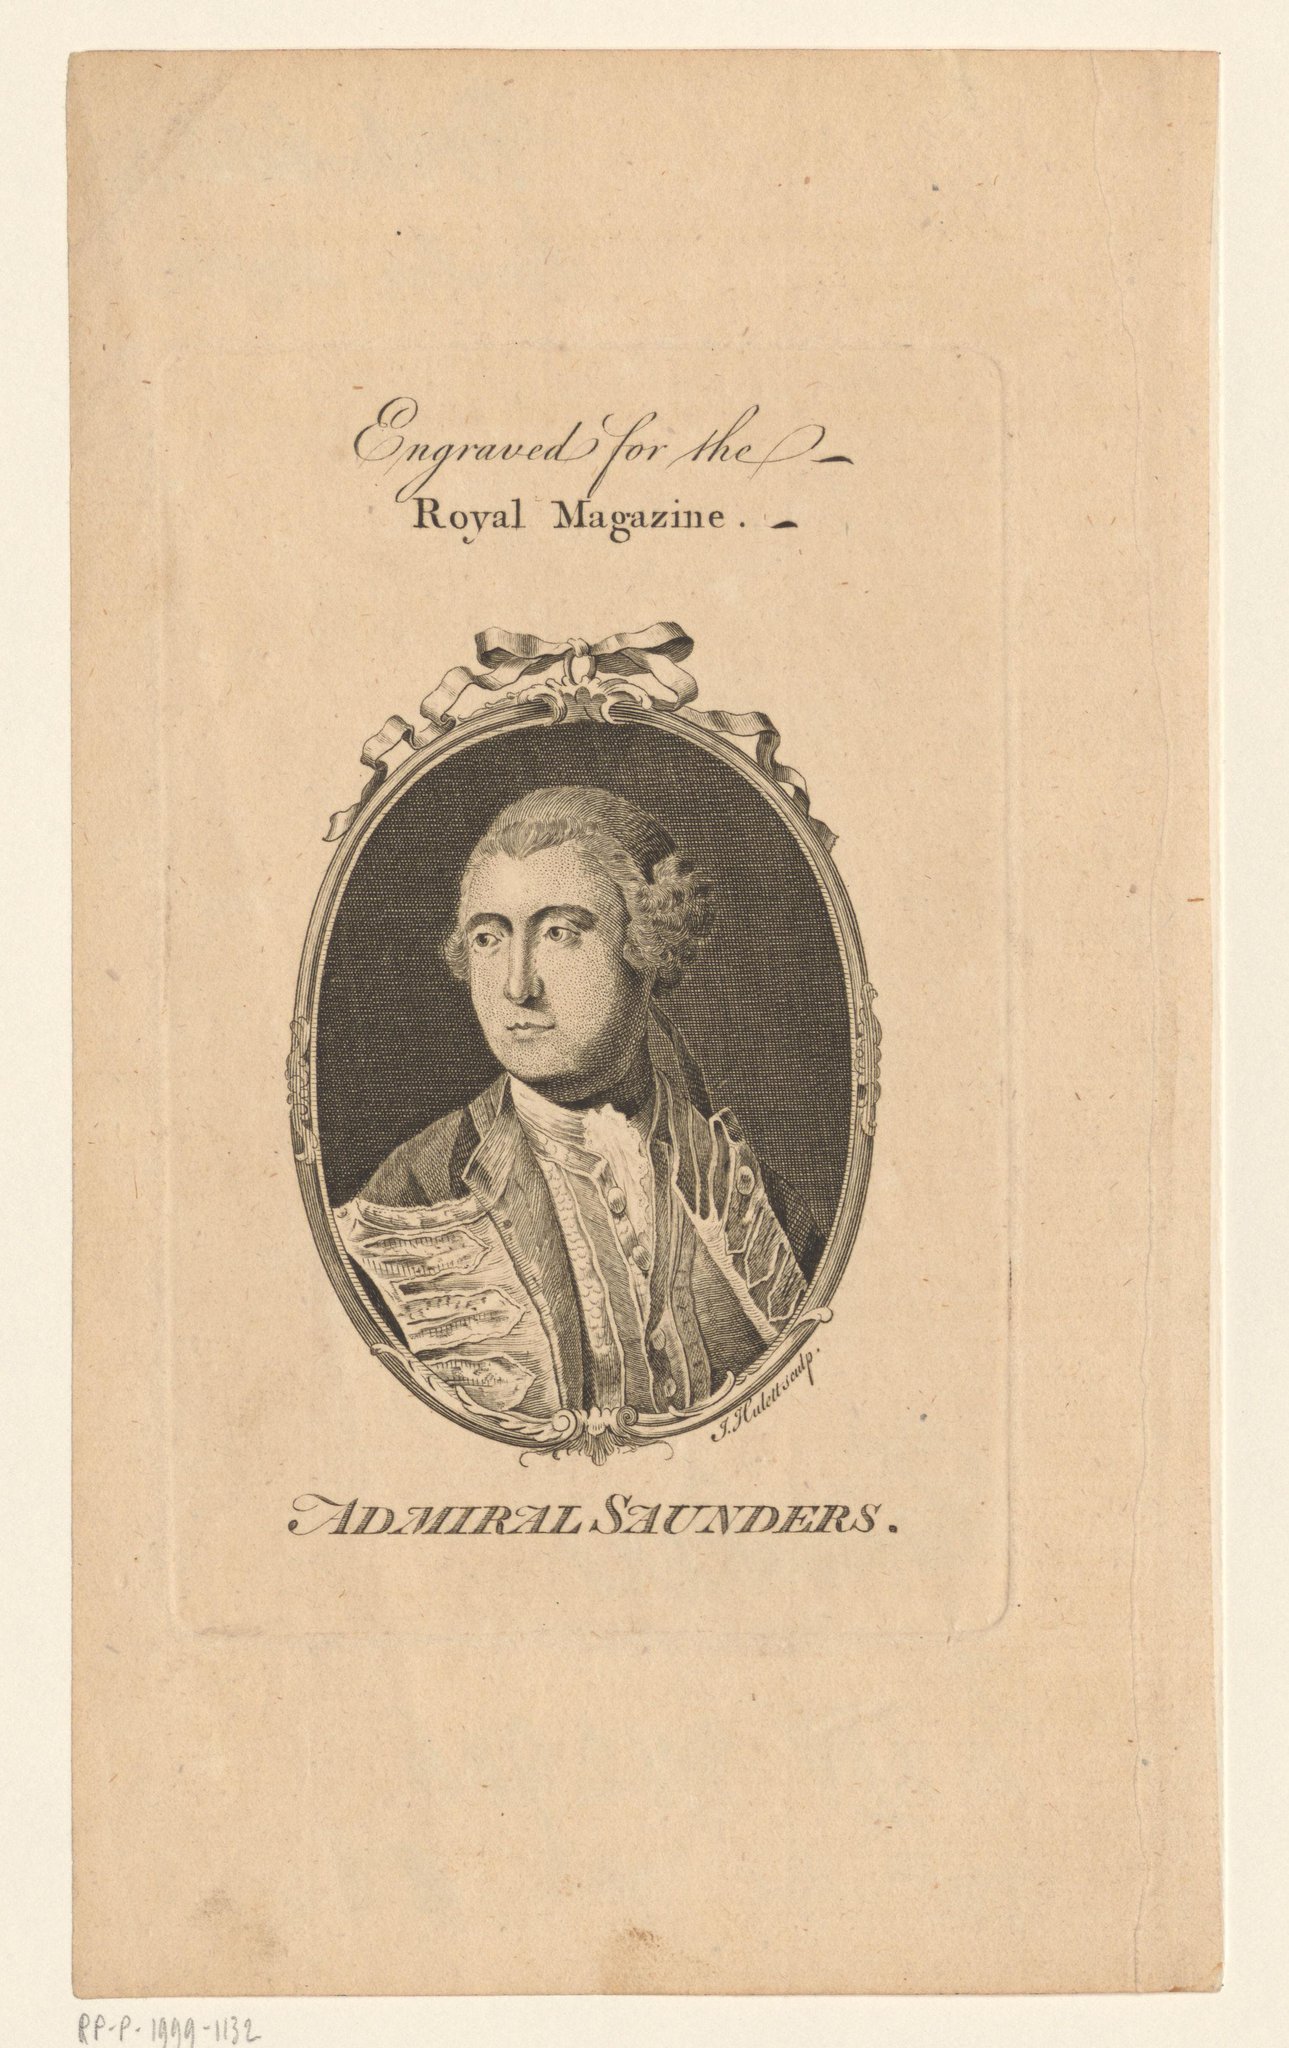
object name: print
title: Portret van Charles Saunders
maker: james hulett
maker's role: print maker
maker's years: -1771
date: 1759-1771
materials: paper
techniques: engraving, etching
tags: london, politician, historical persons, commander-in-chief, admiral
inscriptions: collector's mark: Lugt 2228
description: Deze prent is waarschijnlijk gebruikt in een uitgave van 'The Royal Magazine, Or, Gentleman's Monthly Companion', een tijdschrift dat van 1759 tot 1771 werd uitgegeven door John Coote.